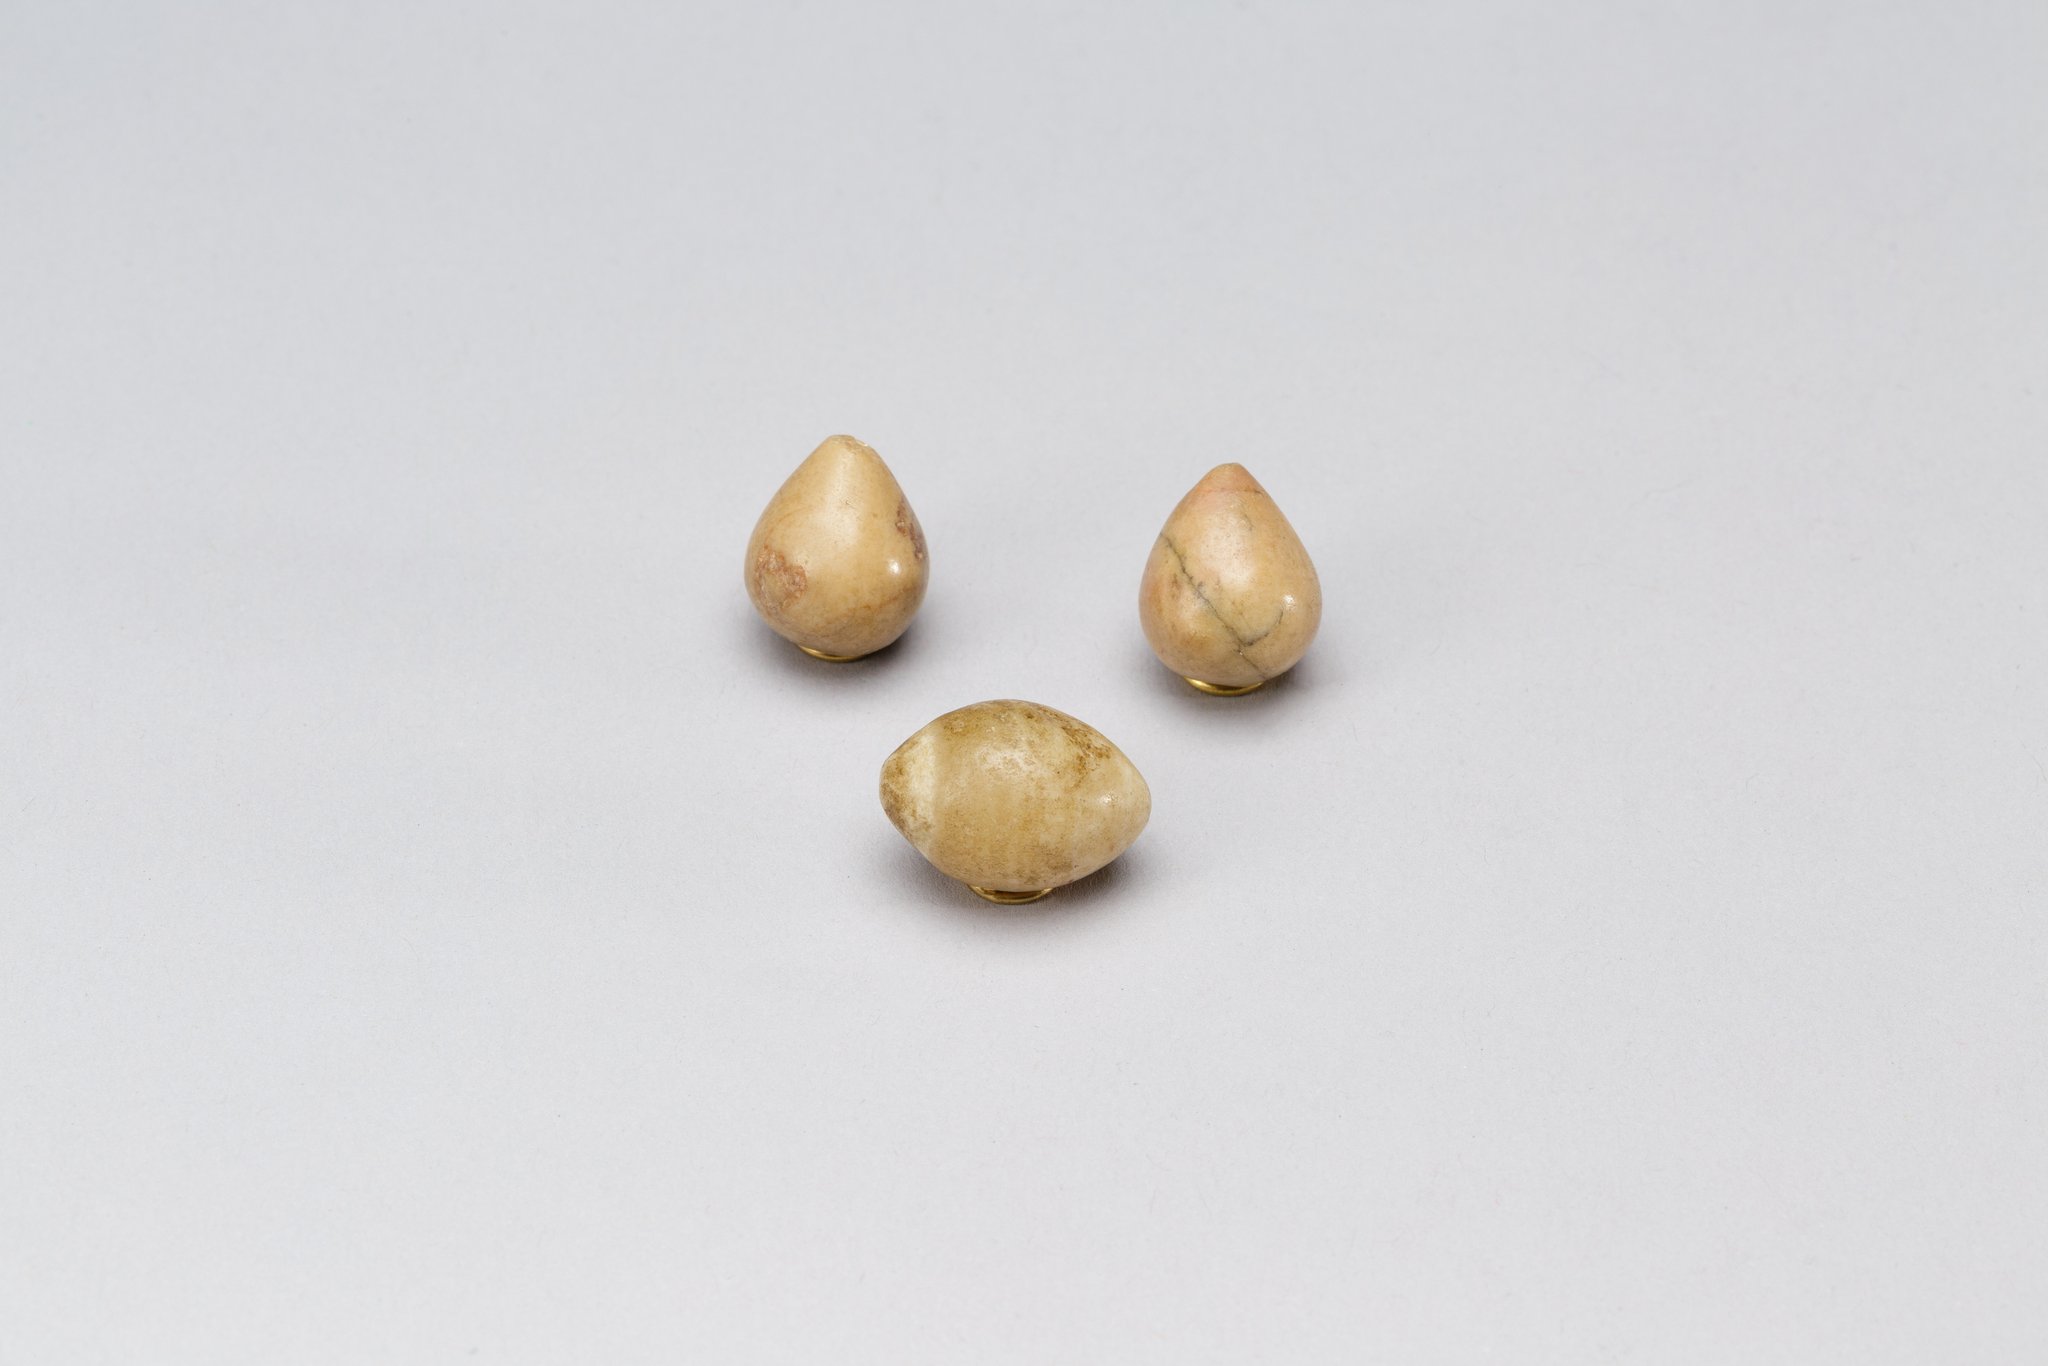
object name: game piece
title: Game Piece (?)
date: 3850-2300 BCE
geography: egypt